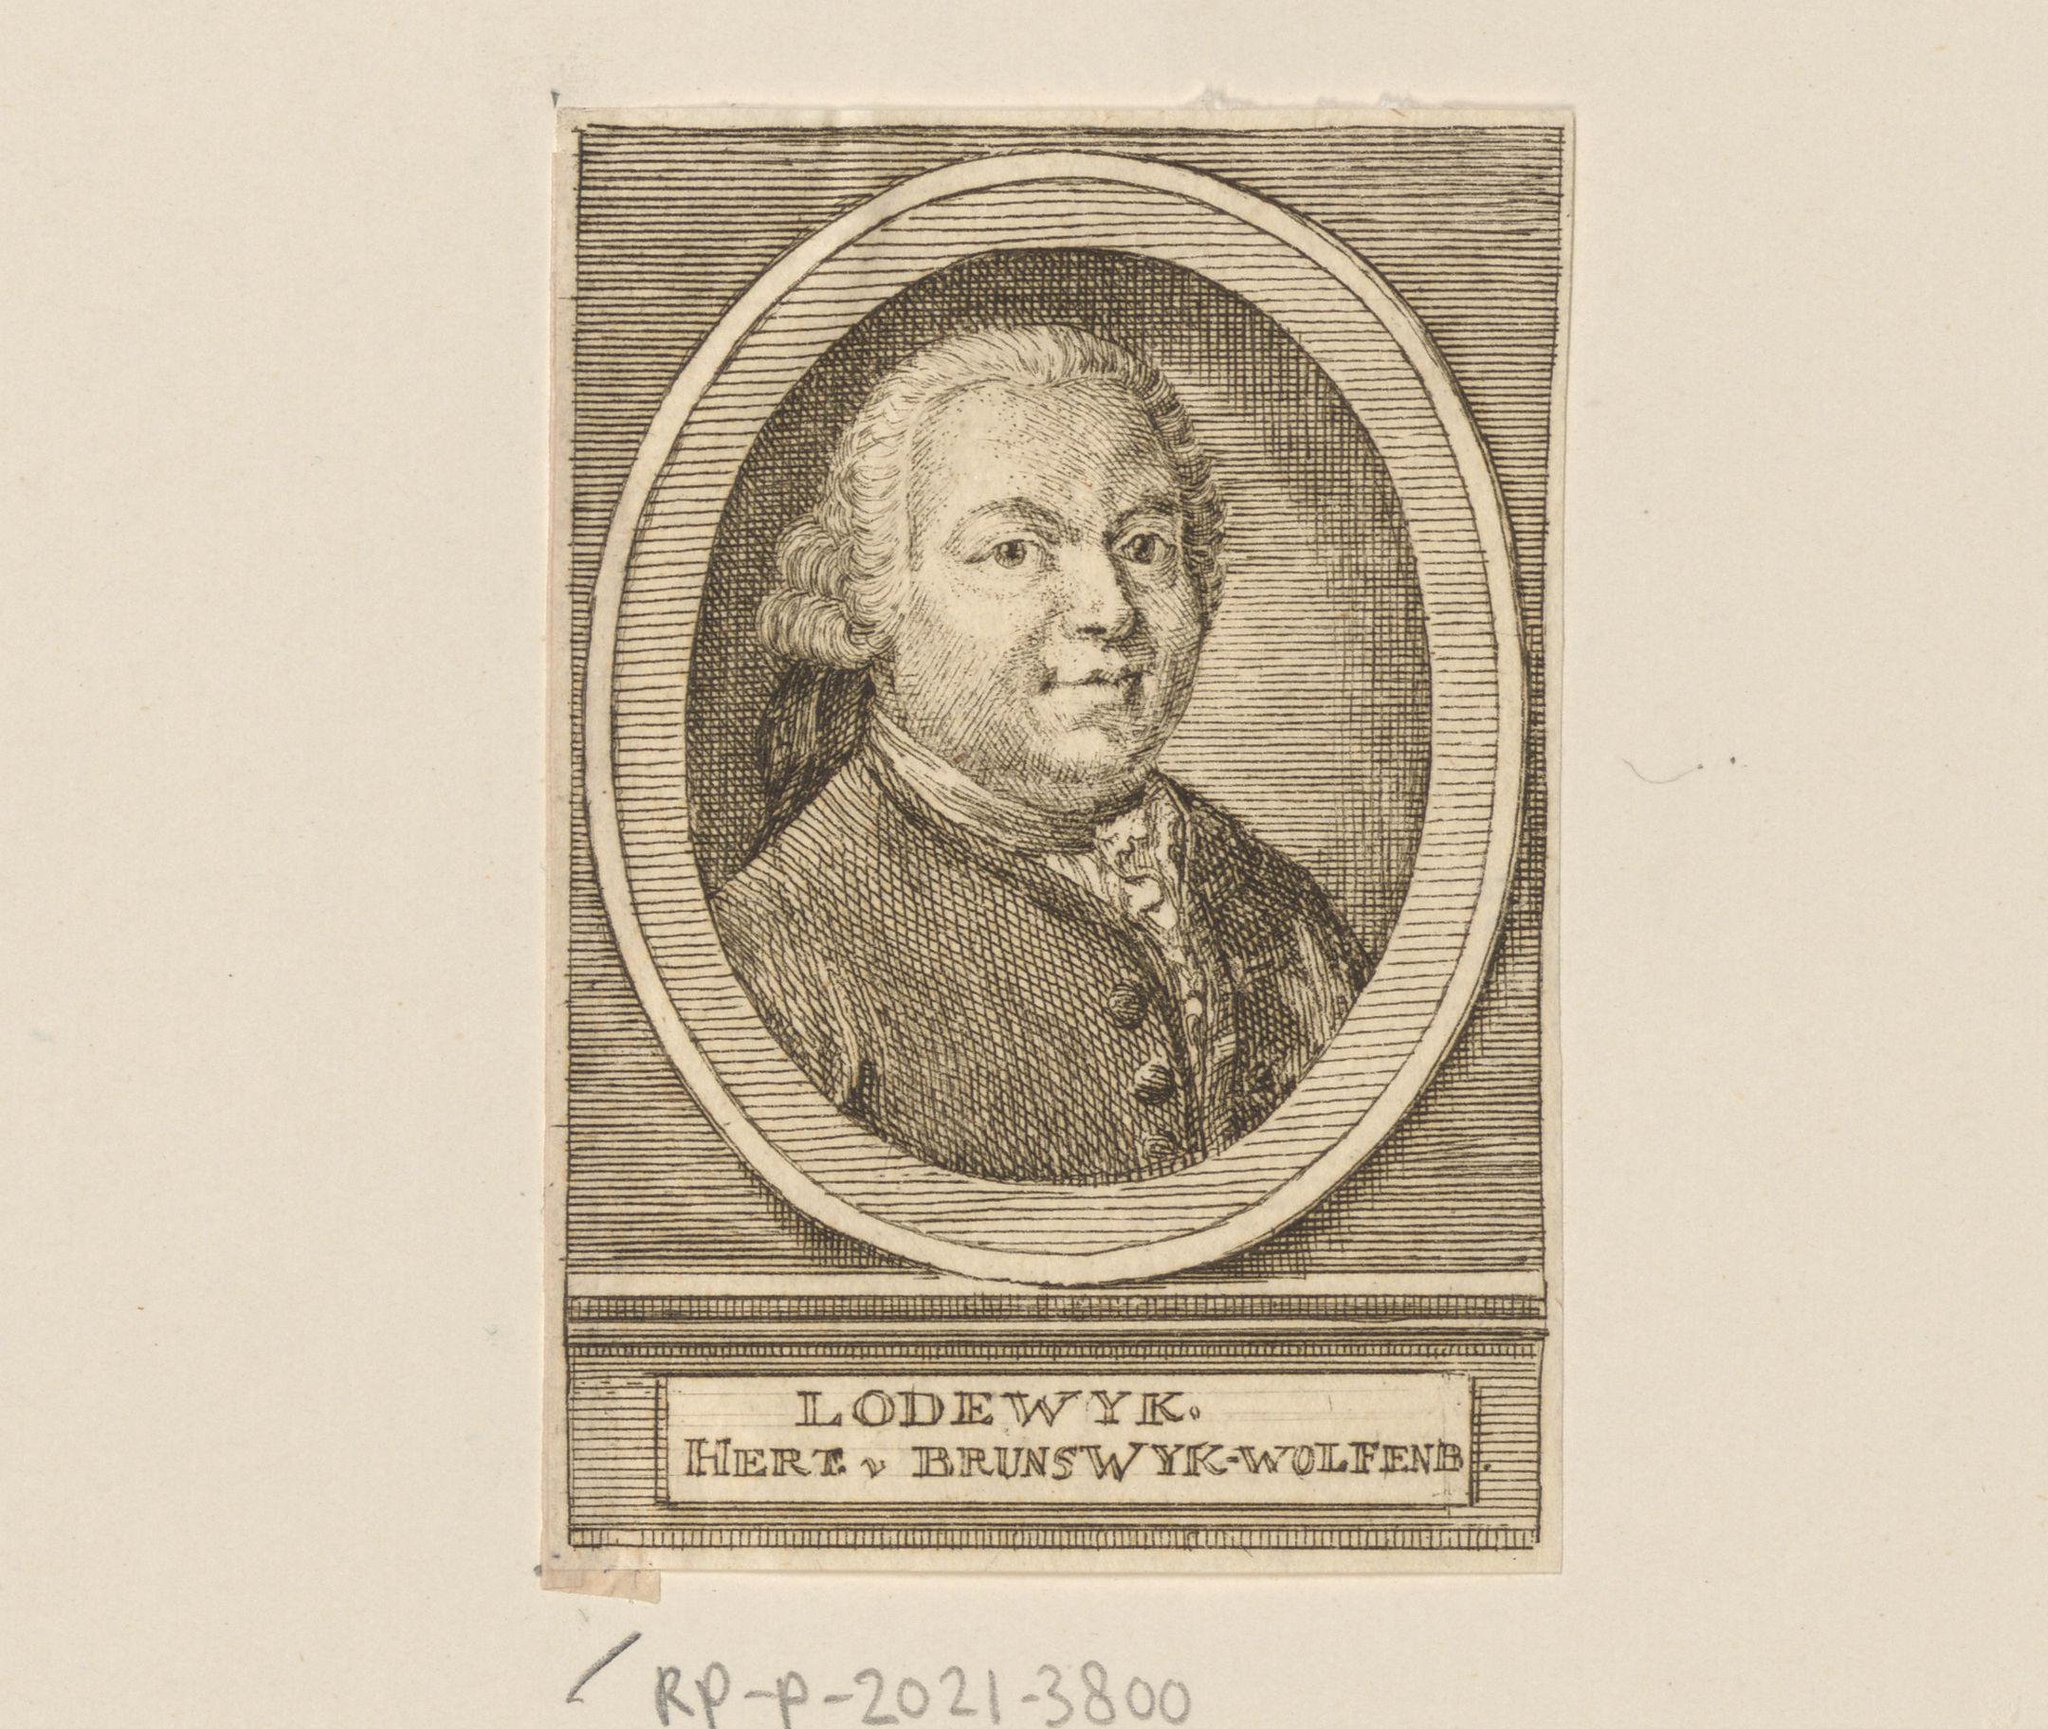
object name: print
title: Portret van Lodewijk Ernst, hertog van Brunswijk-Wolfenbüttel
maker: Anonymous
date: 1750-1799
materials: paper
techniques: etching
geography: northern netherlands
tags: ludwig ernst von braunschweig-wolfenbüttel, historical persons, wig